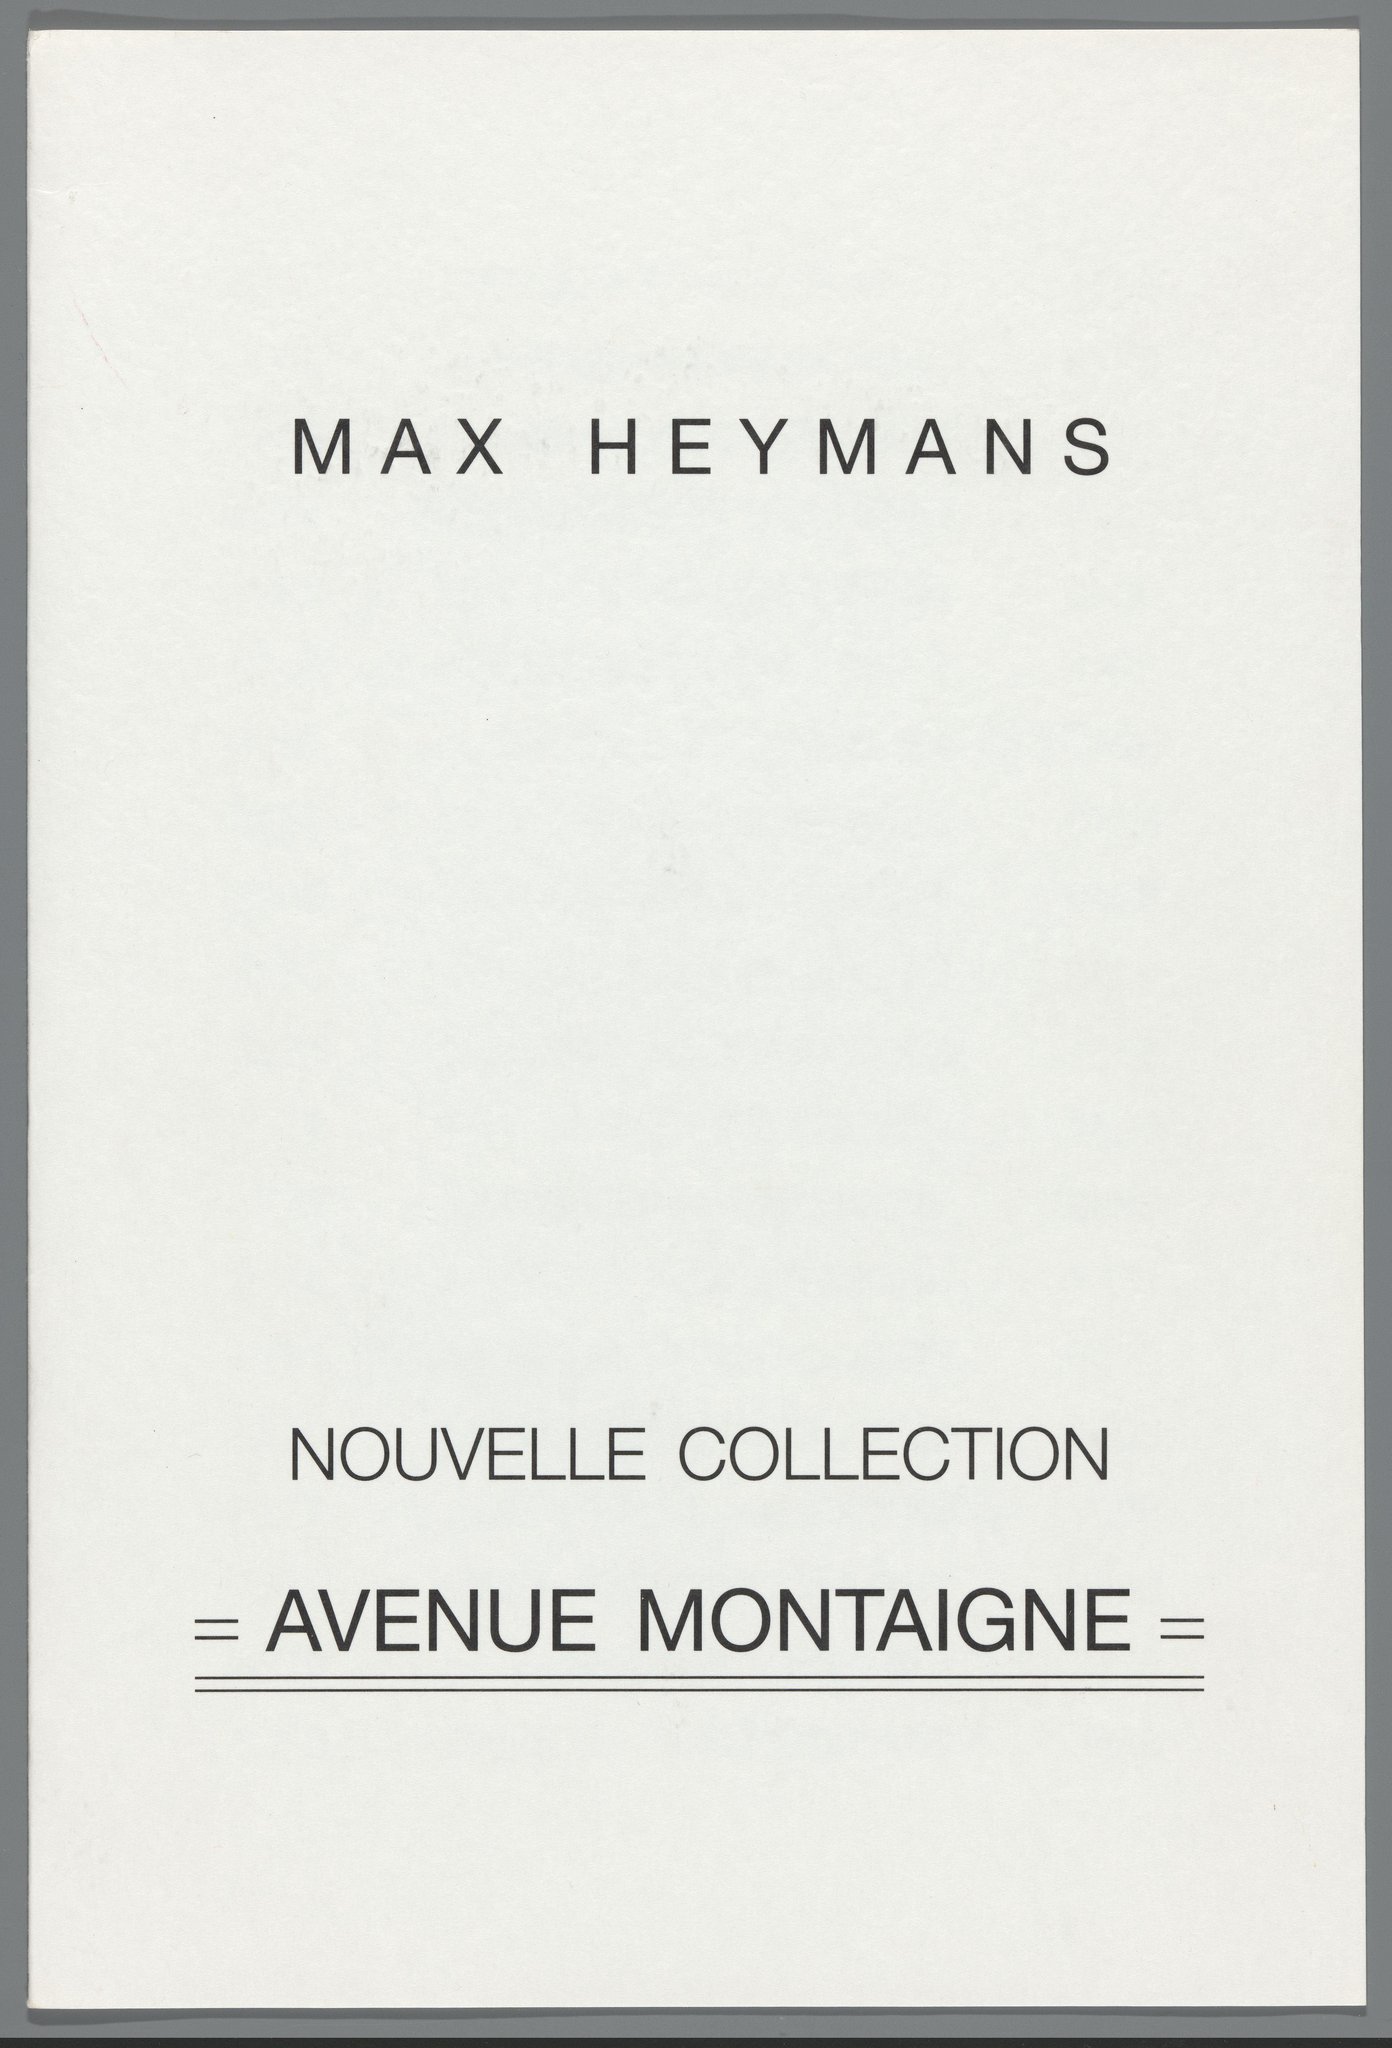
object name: printed matter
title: Nouvelle Collection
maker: Anonymous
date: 1970-1997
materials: paper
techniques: printed materials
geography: netherlands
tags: max heymans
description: Gevouwen blad met informatie over modeshow met couture van Max Heymans.